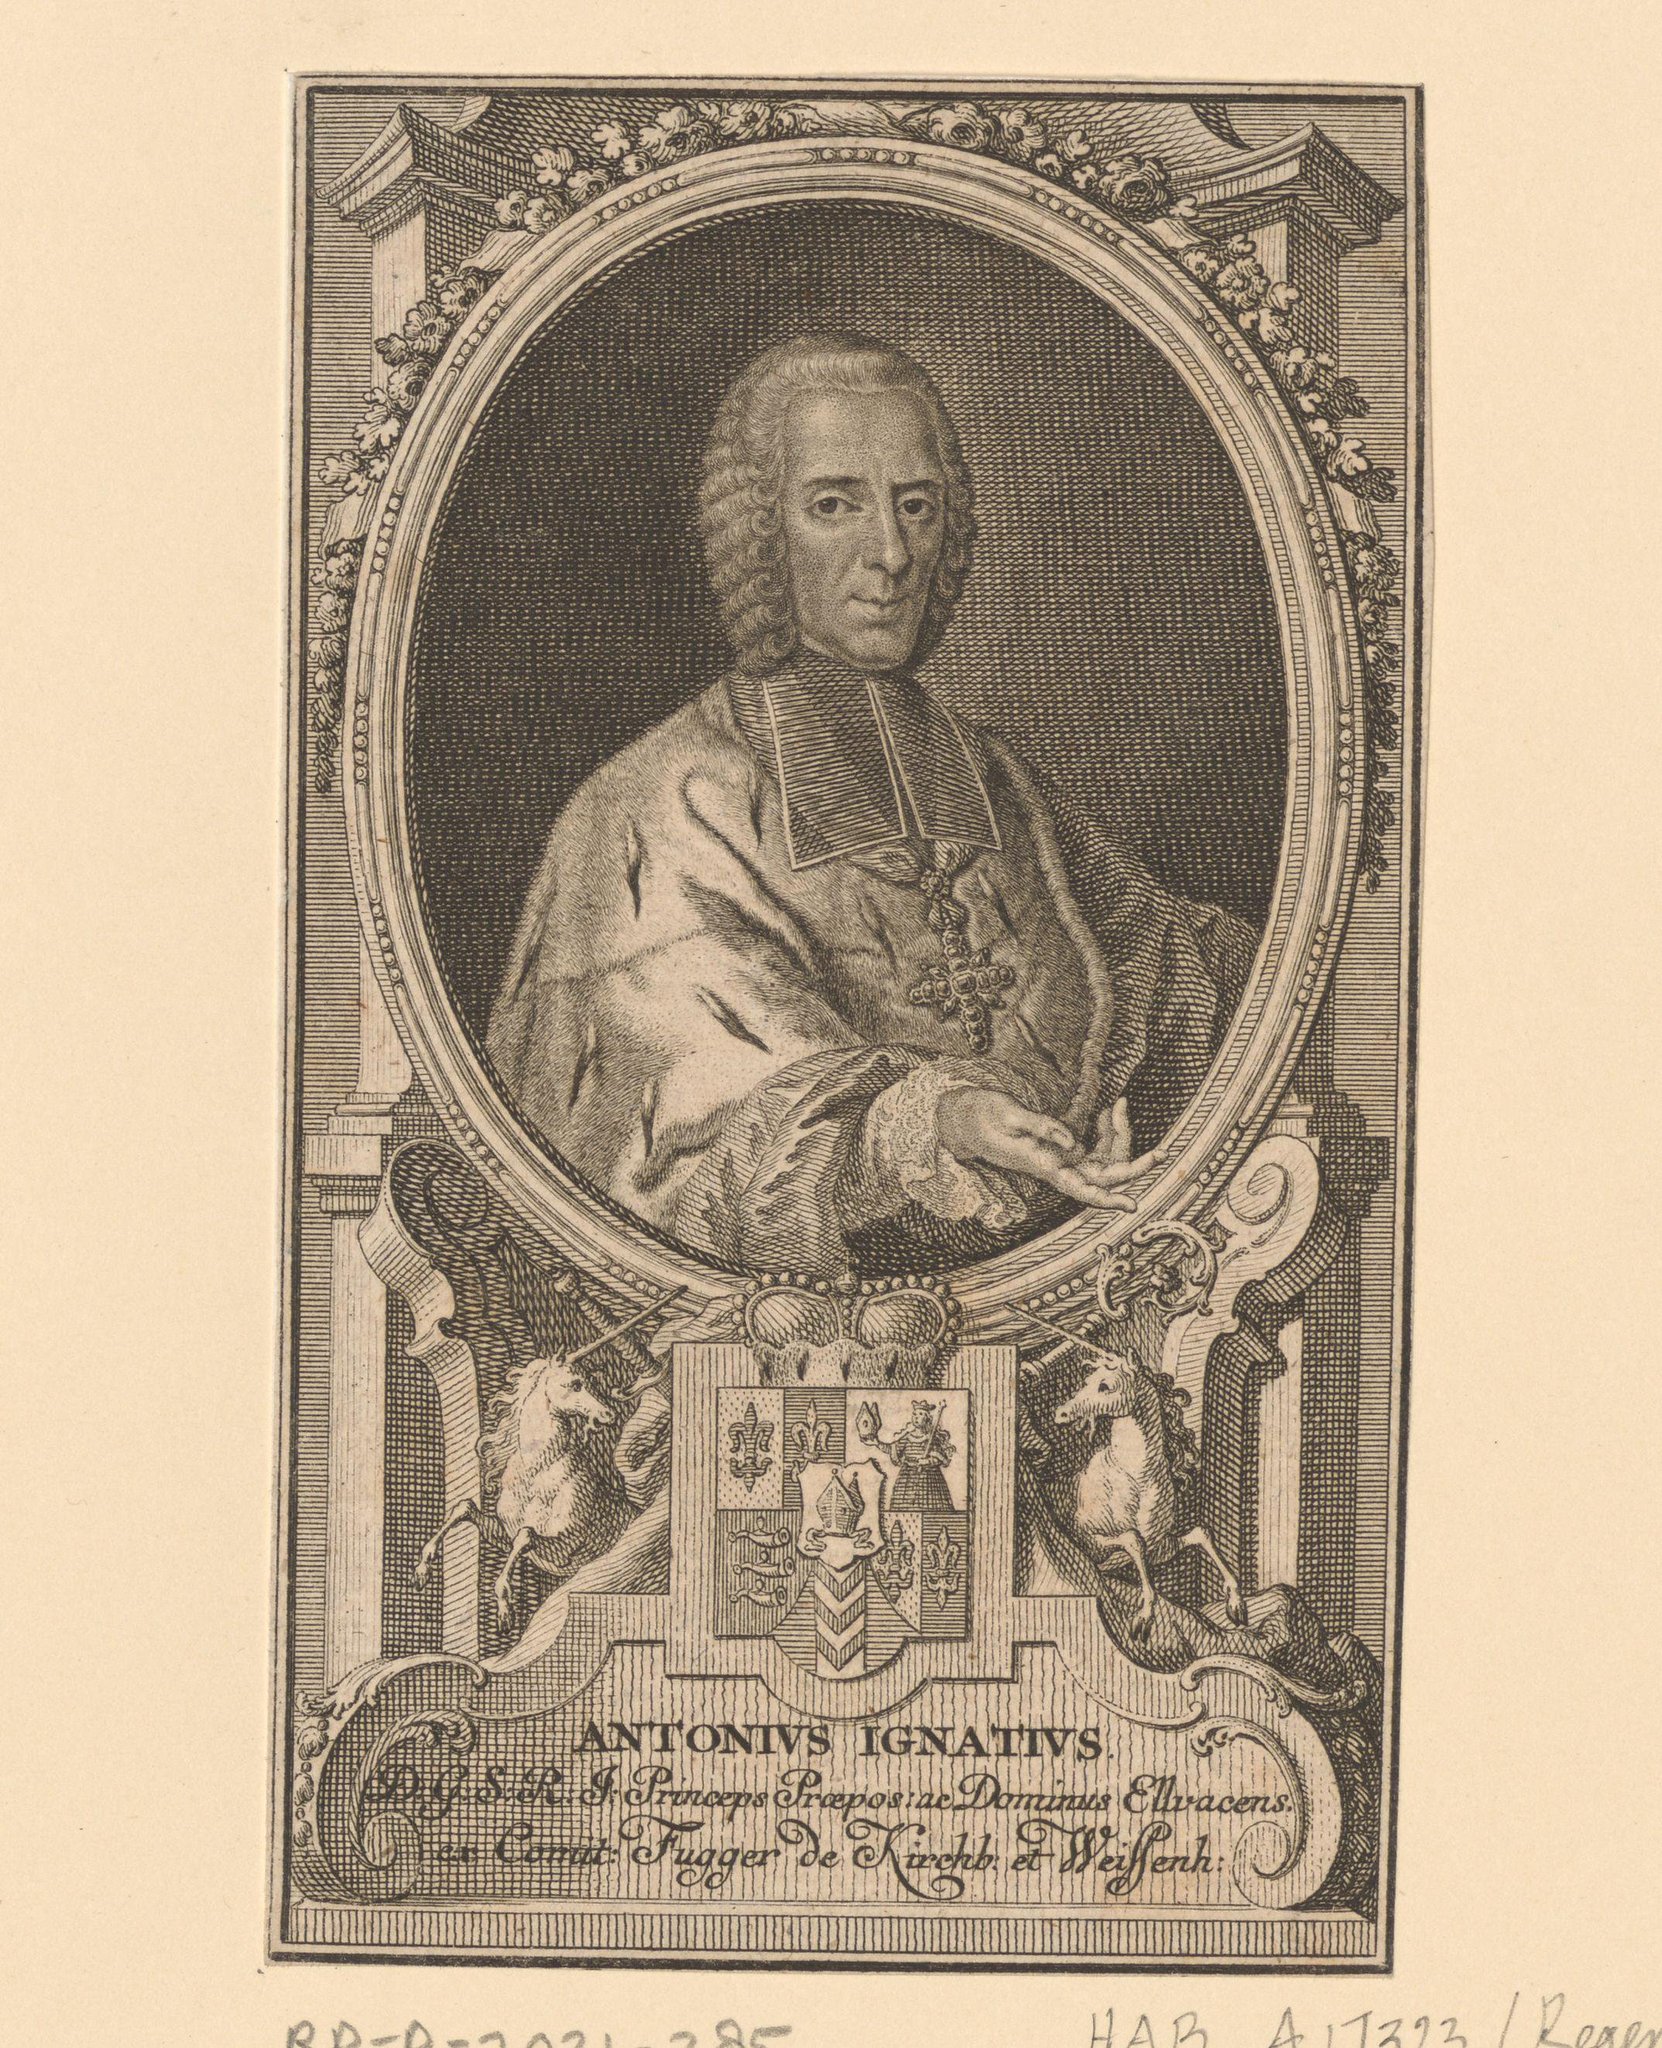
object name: print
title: Portret van Anton Ignaz von Fugger-Glött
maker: johann esaias nilson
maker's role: draughtsman, print maker, publisher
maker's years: 1721-1788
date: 1769-1788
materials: paper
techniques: etching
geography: germany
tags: archbishop, bishop, etc. (roman catholic), unicorn, ornament ~ medallion, historical persons, armorial bearing, heraldry